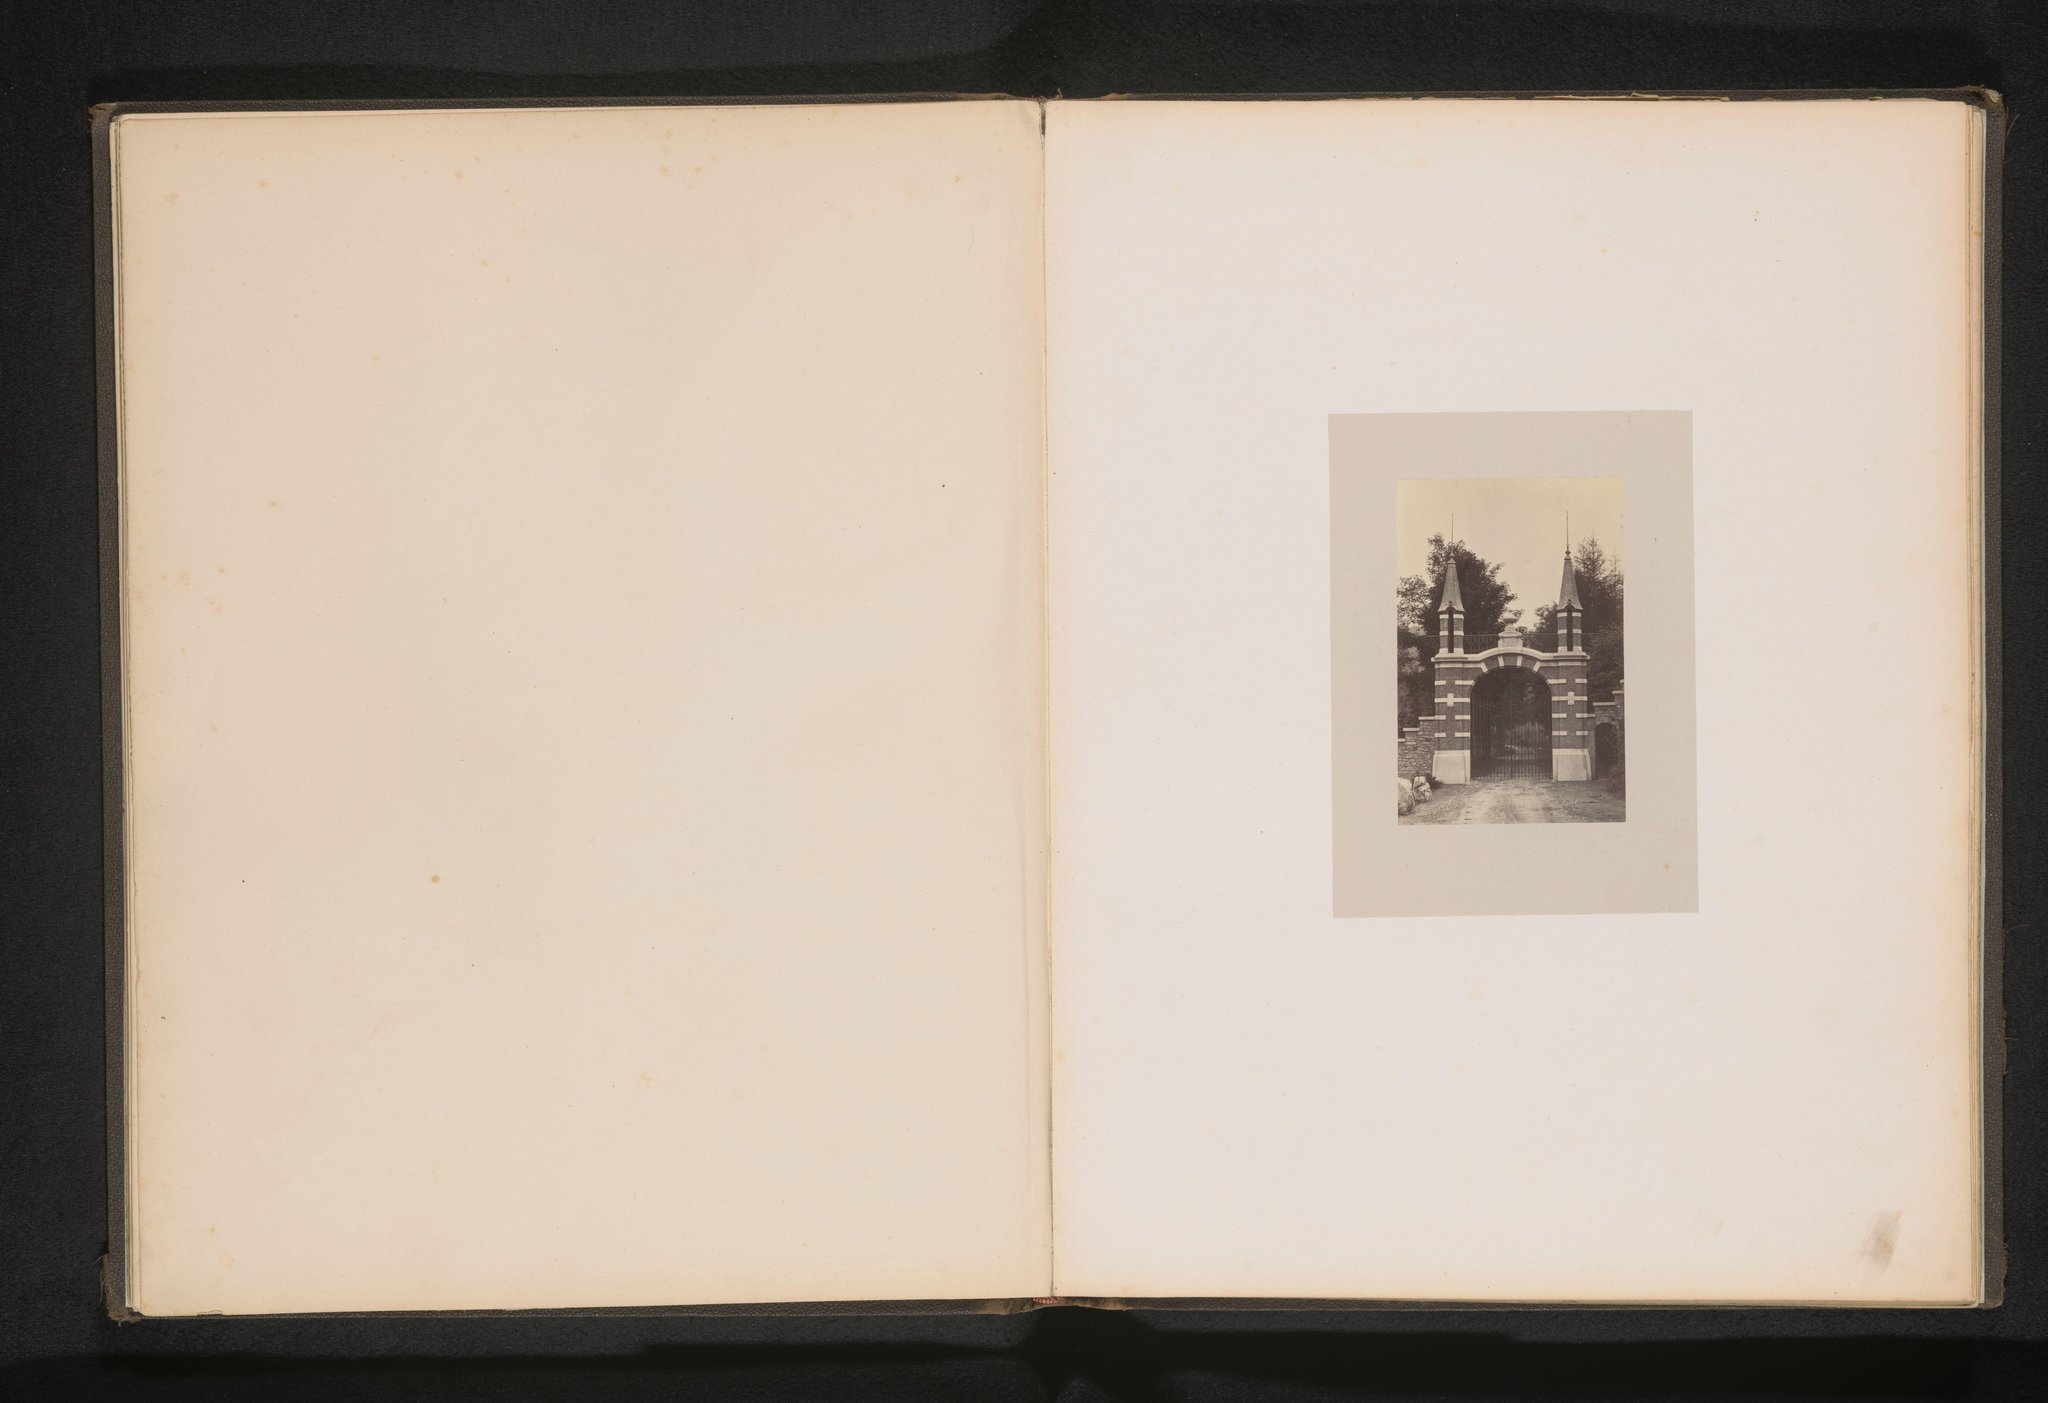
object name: photograph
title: Gezicht op een poort nabij Wépion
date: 1862-1867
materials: photographic support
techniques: albumen print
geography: wépion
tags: gate, entrance